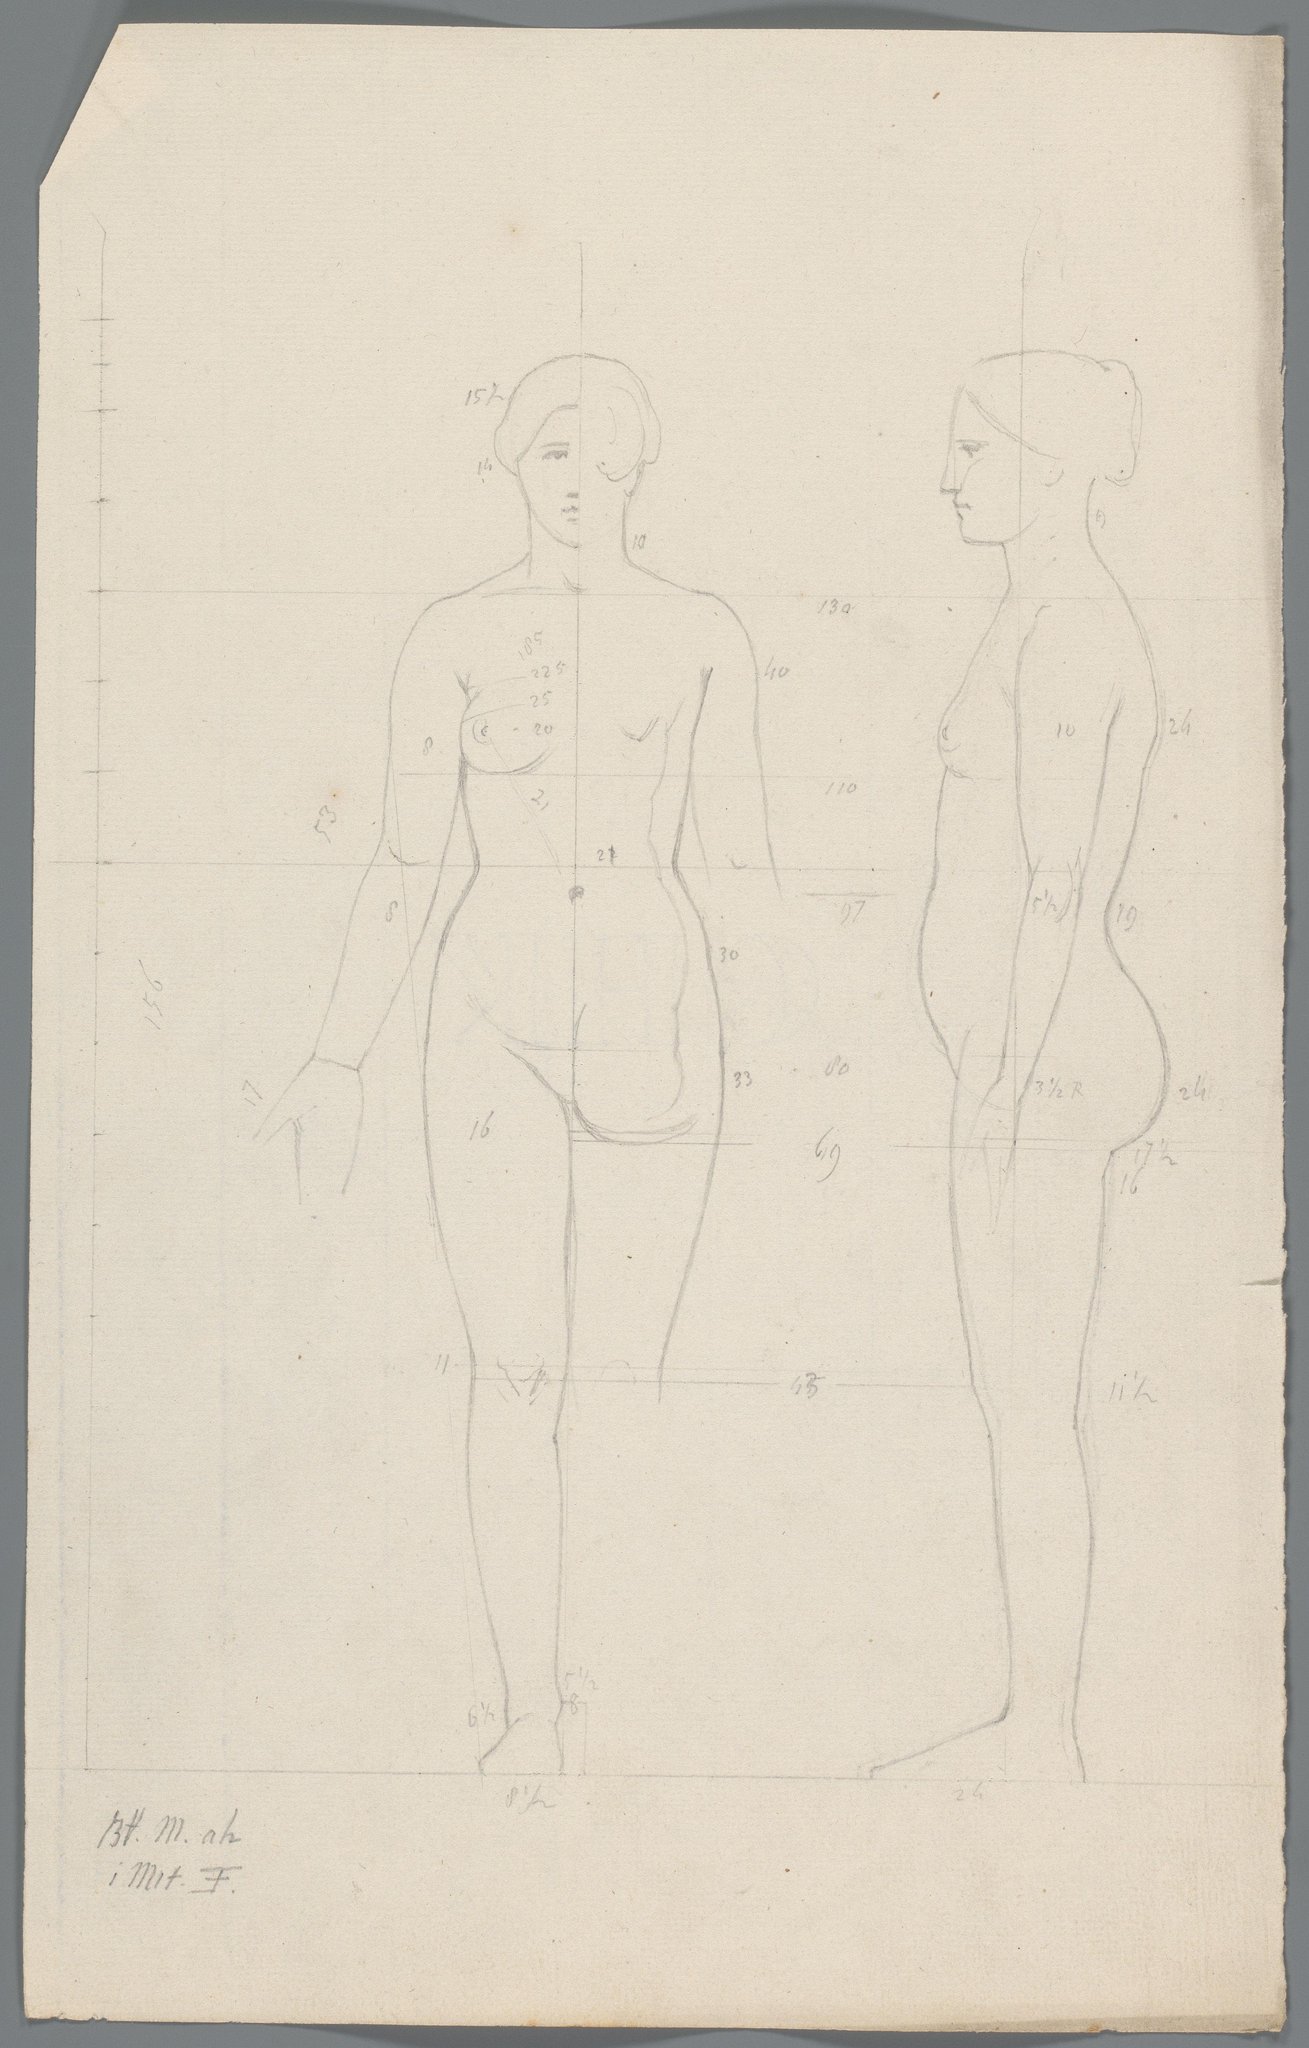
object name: drawing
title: Proportiestudie van een vrouw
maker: jacobus everhardus josephus van den berg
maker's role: draughtsman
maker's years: 1802-1861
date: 1856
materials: paper, pencil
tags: standing figure (canon, proportions) - aa - female human figure, anatomy (non-medical) - aa - female human figure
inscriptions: inscription: ‘BT M. ah/ 1 Mit EF.’